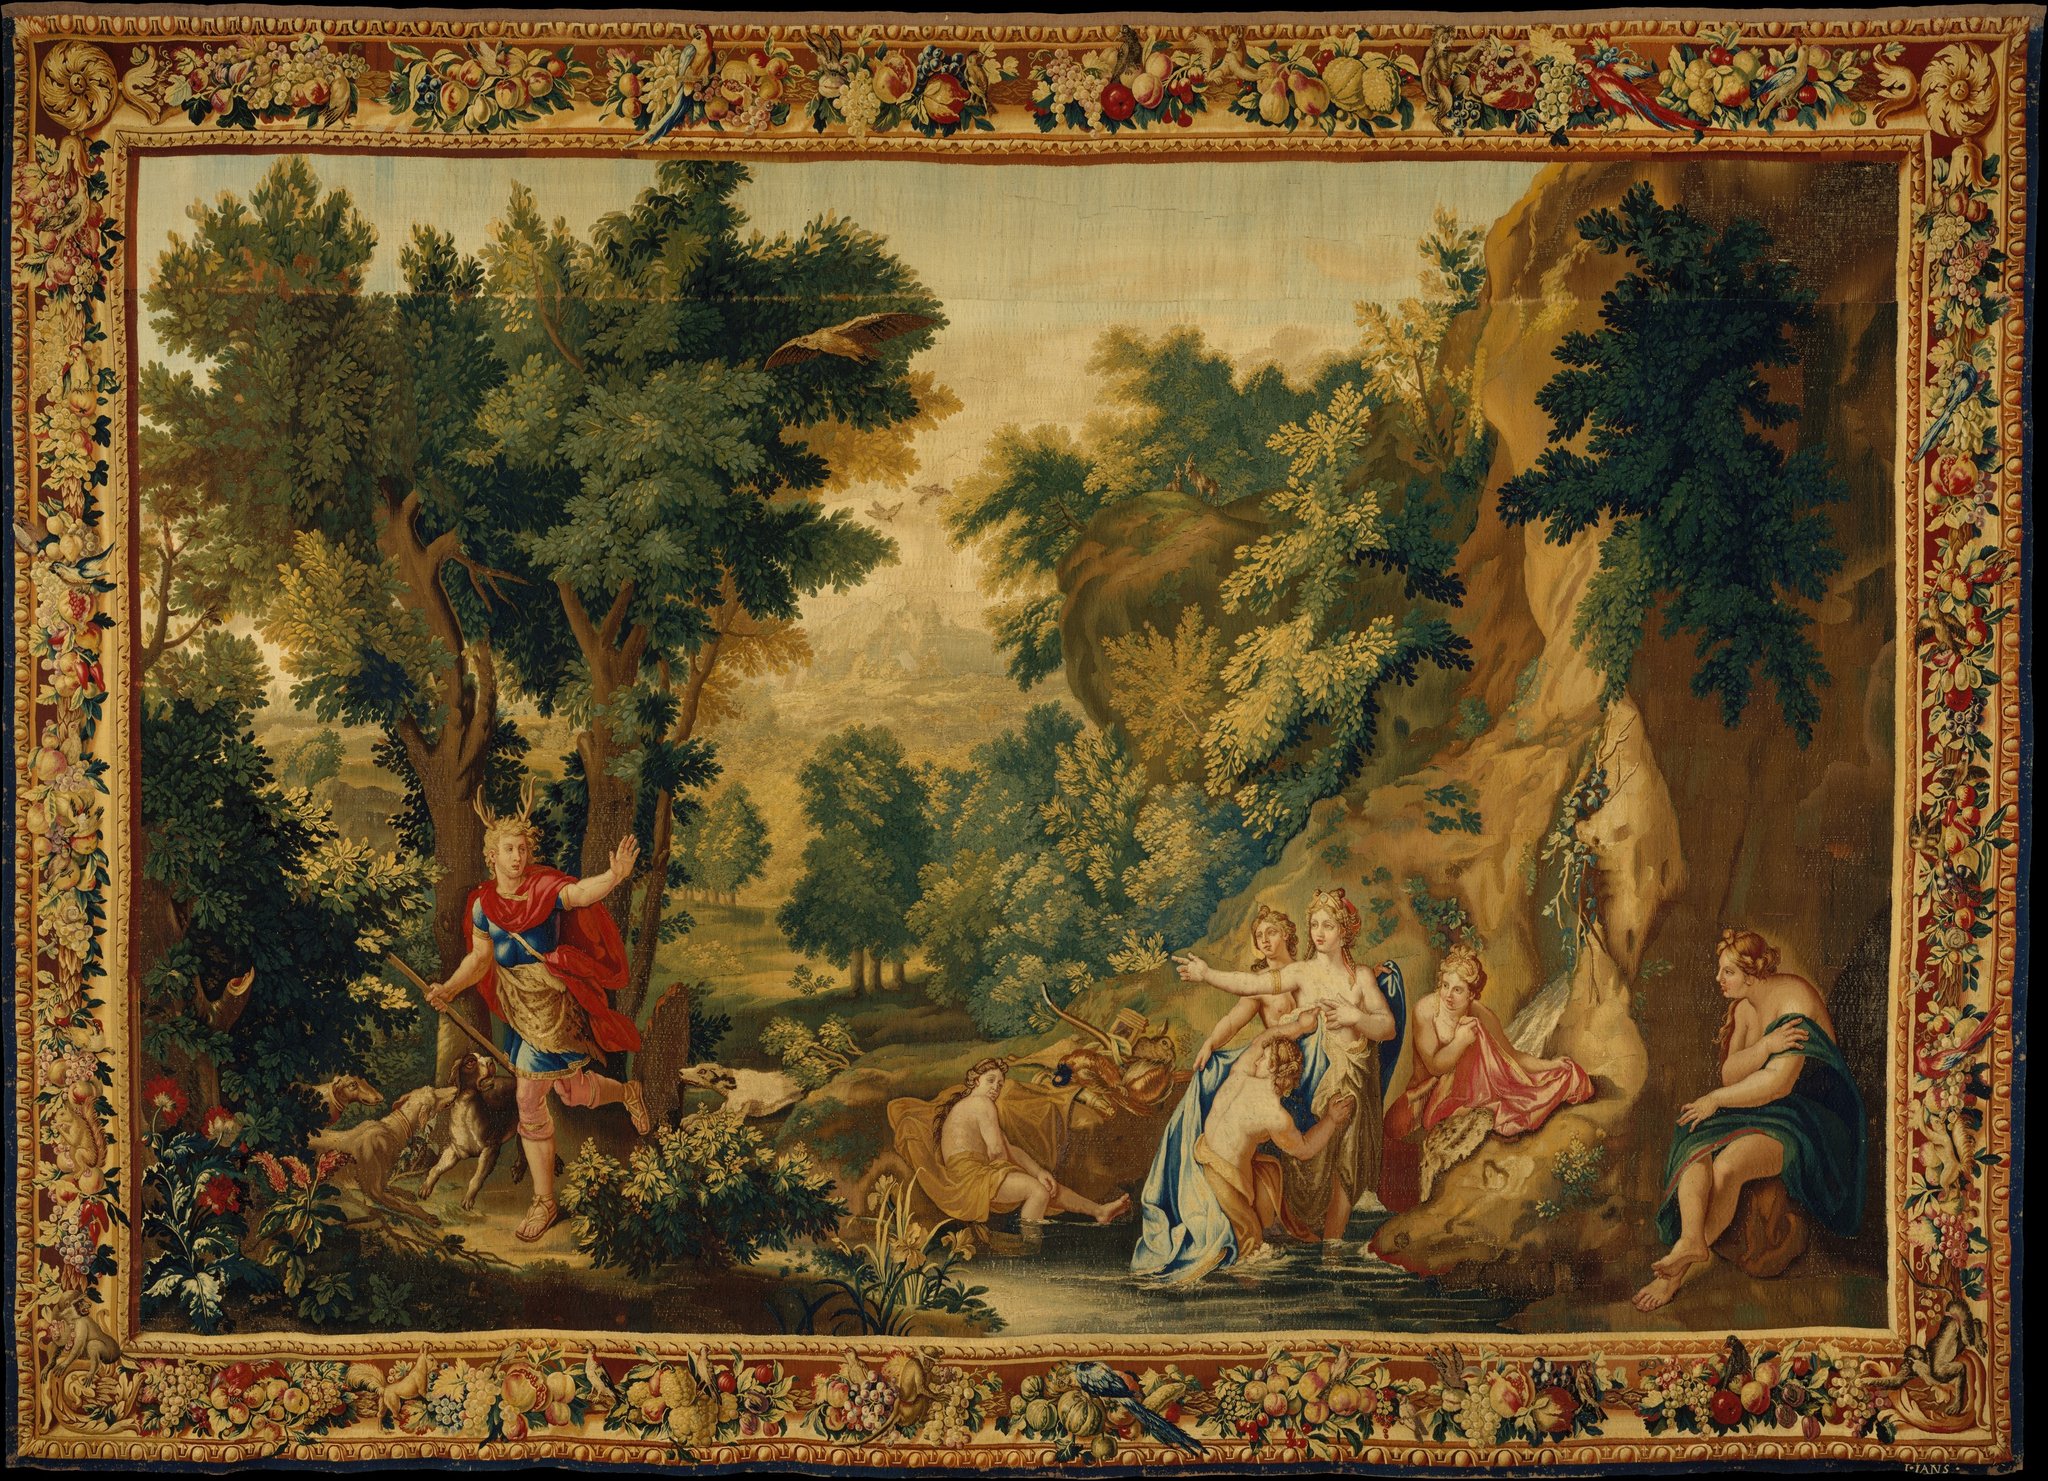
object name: tapestry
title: Diana and Actaeon from a set of Ovid's Metamorphoses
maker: manufacture nationale des gobelins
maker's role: manufactory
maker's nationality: french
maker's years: 1662-1799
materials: silk, wool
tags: women,actaeon,nymphs,diana,dogs,bathing